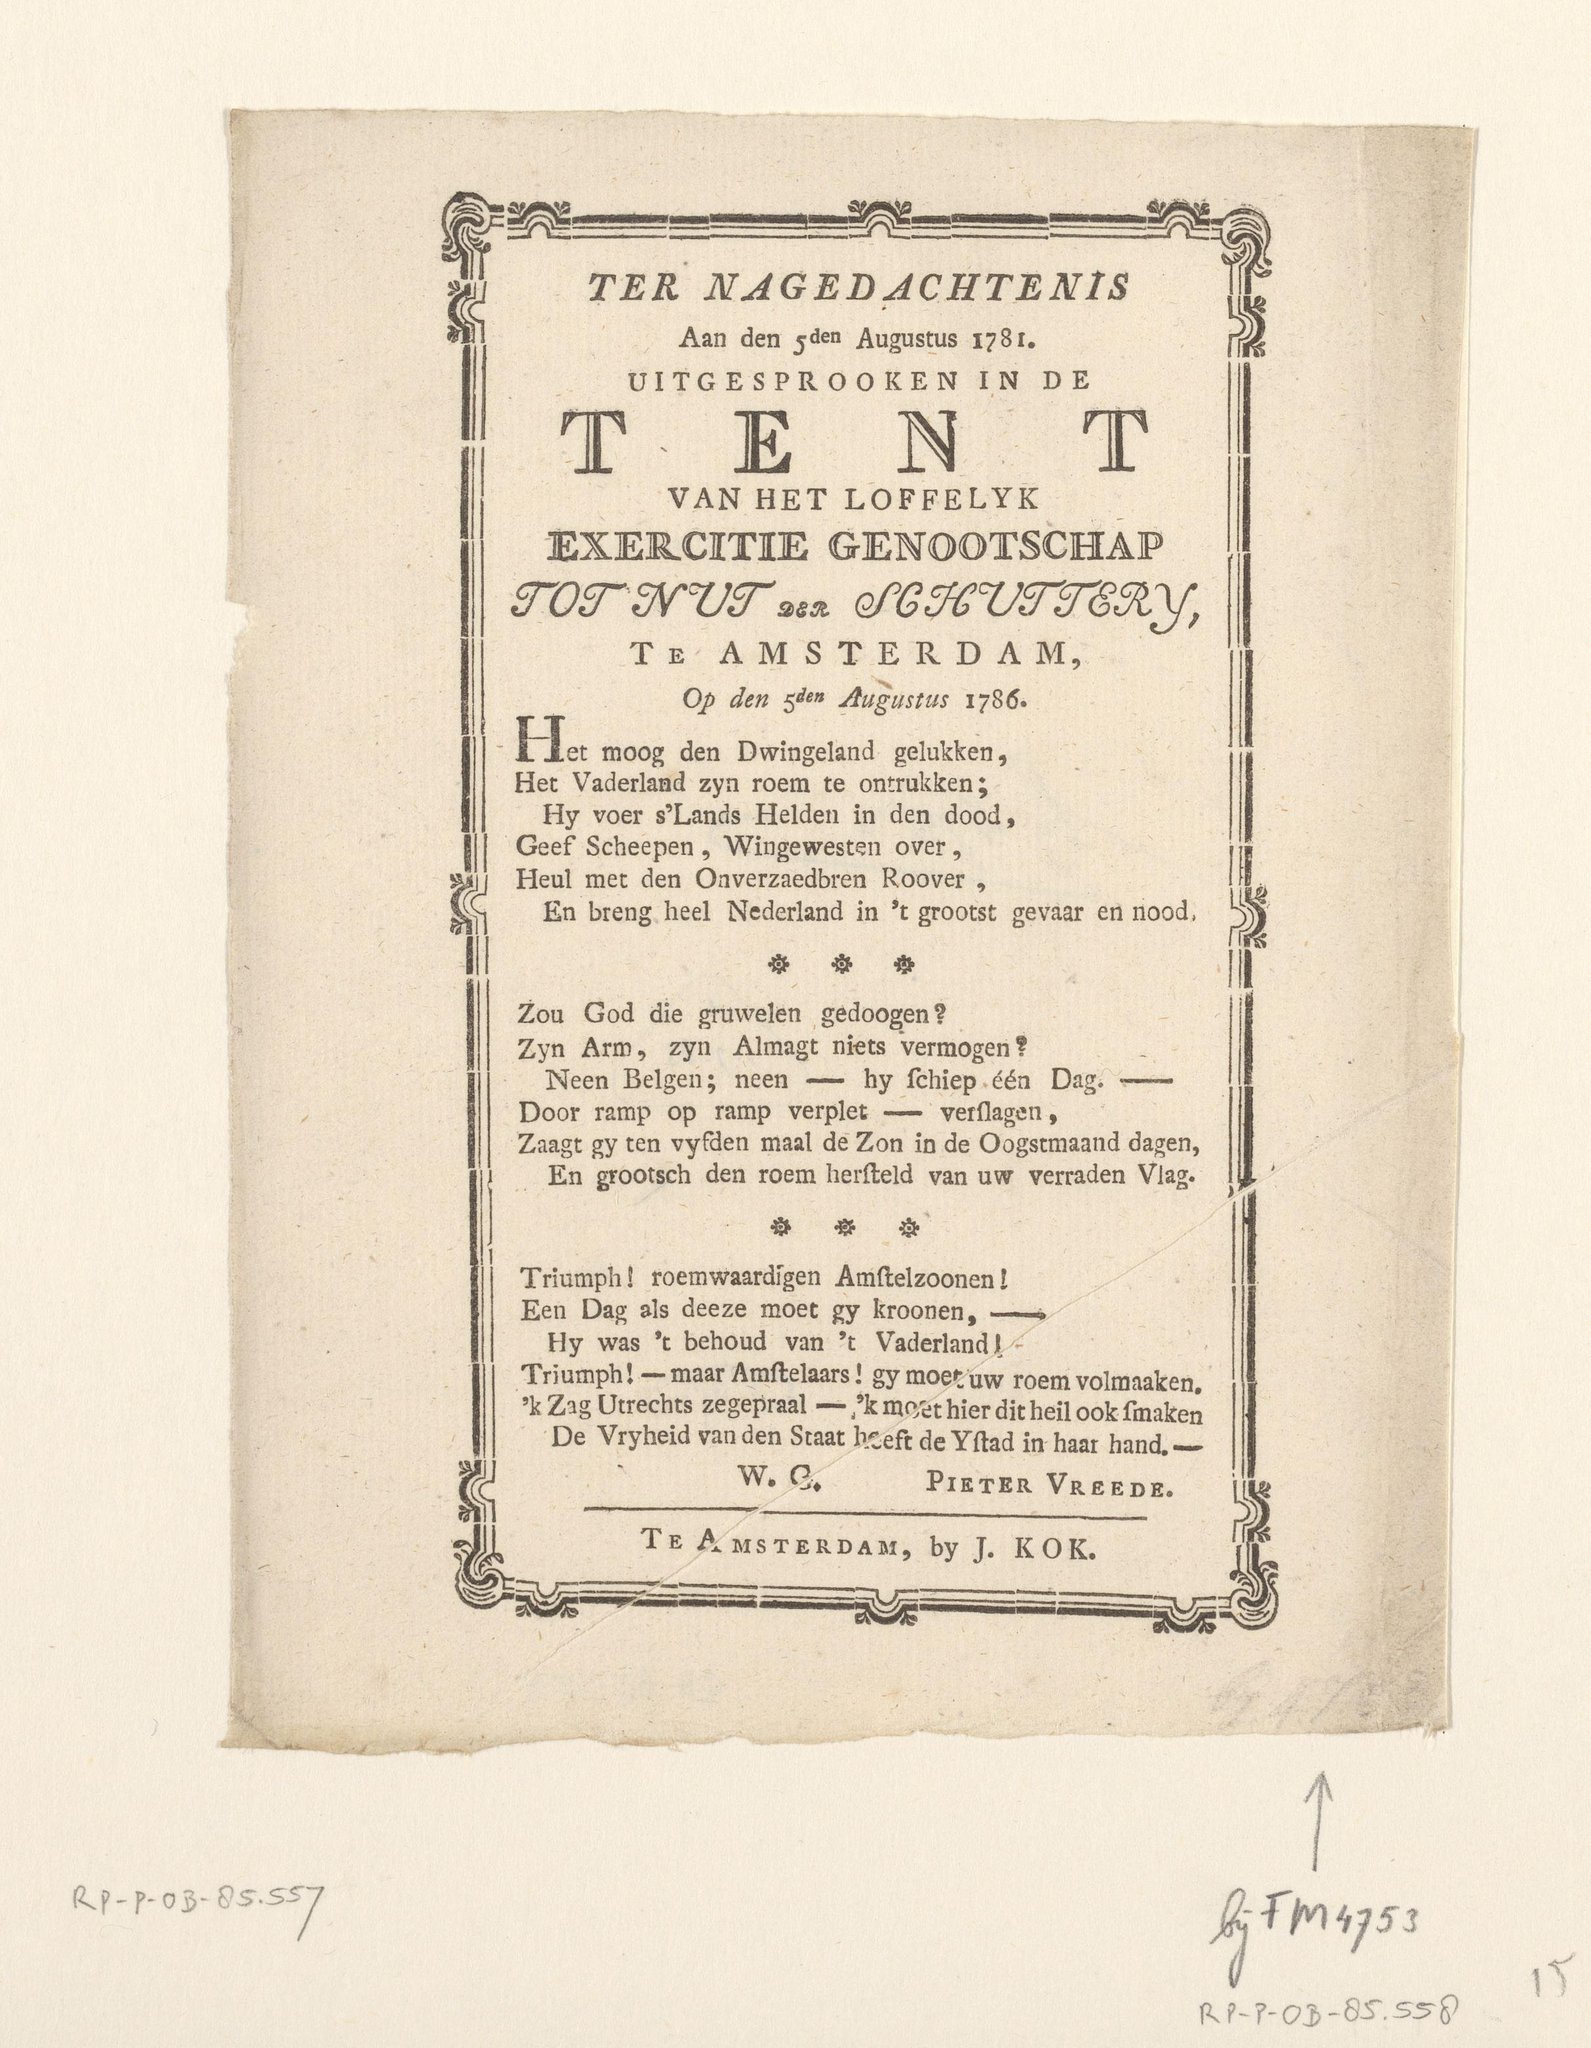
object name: text sheet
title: Vers ter nagedachtenis aan de slag bij Doggersbank, 1786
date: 1708-1786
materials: paper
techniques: letterpress printing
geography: amsterdam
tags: amsterdam, patriots (1780-1795)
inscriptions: collector's mark: Lugt 2228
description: Tekstblad met een vers ter gelegenheid van het vijf-jarig jubileum van de slag bij Doggersbank (5 augustus 1781), uitgesproken op 5 augustus 1786 in een tent van het Amsterdamse exercitiegenootschap Tot Nut der Schuttery. Tekstblad bedrukt op één zijde.